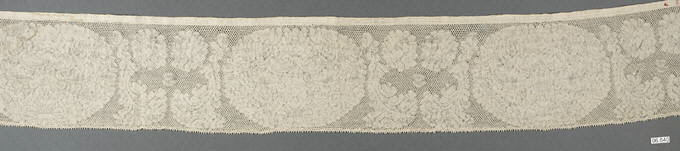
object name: strip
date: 1750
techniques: lace